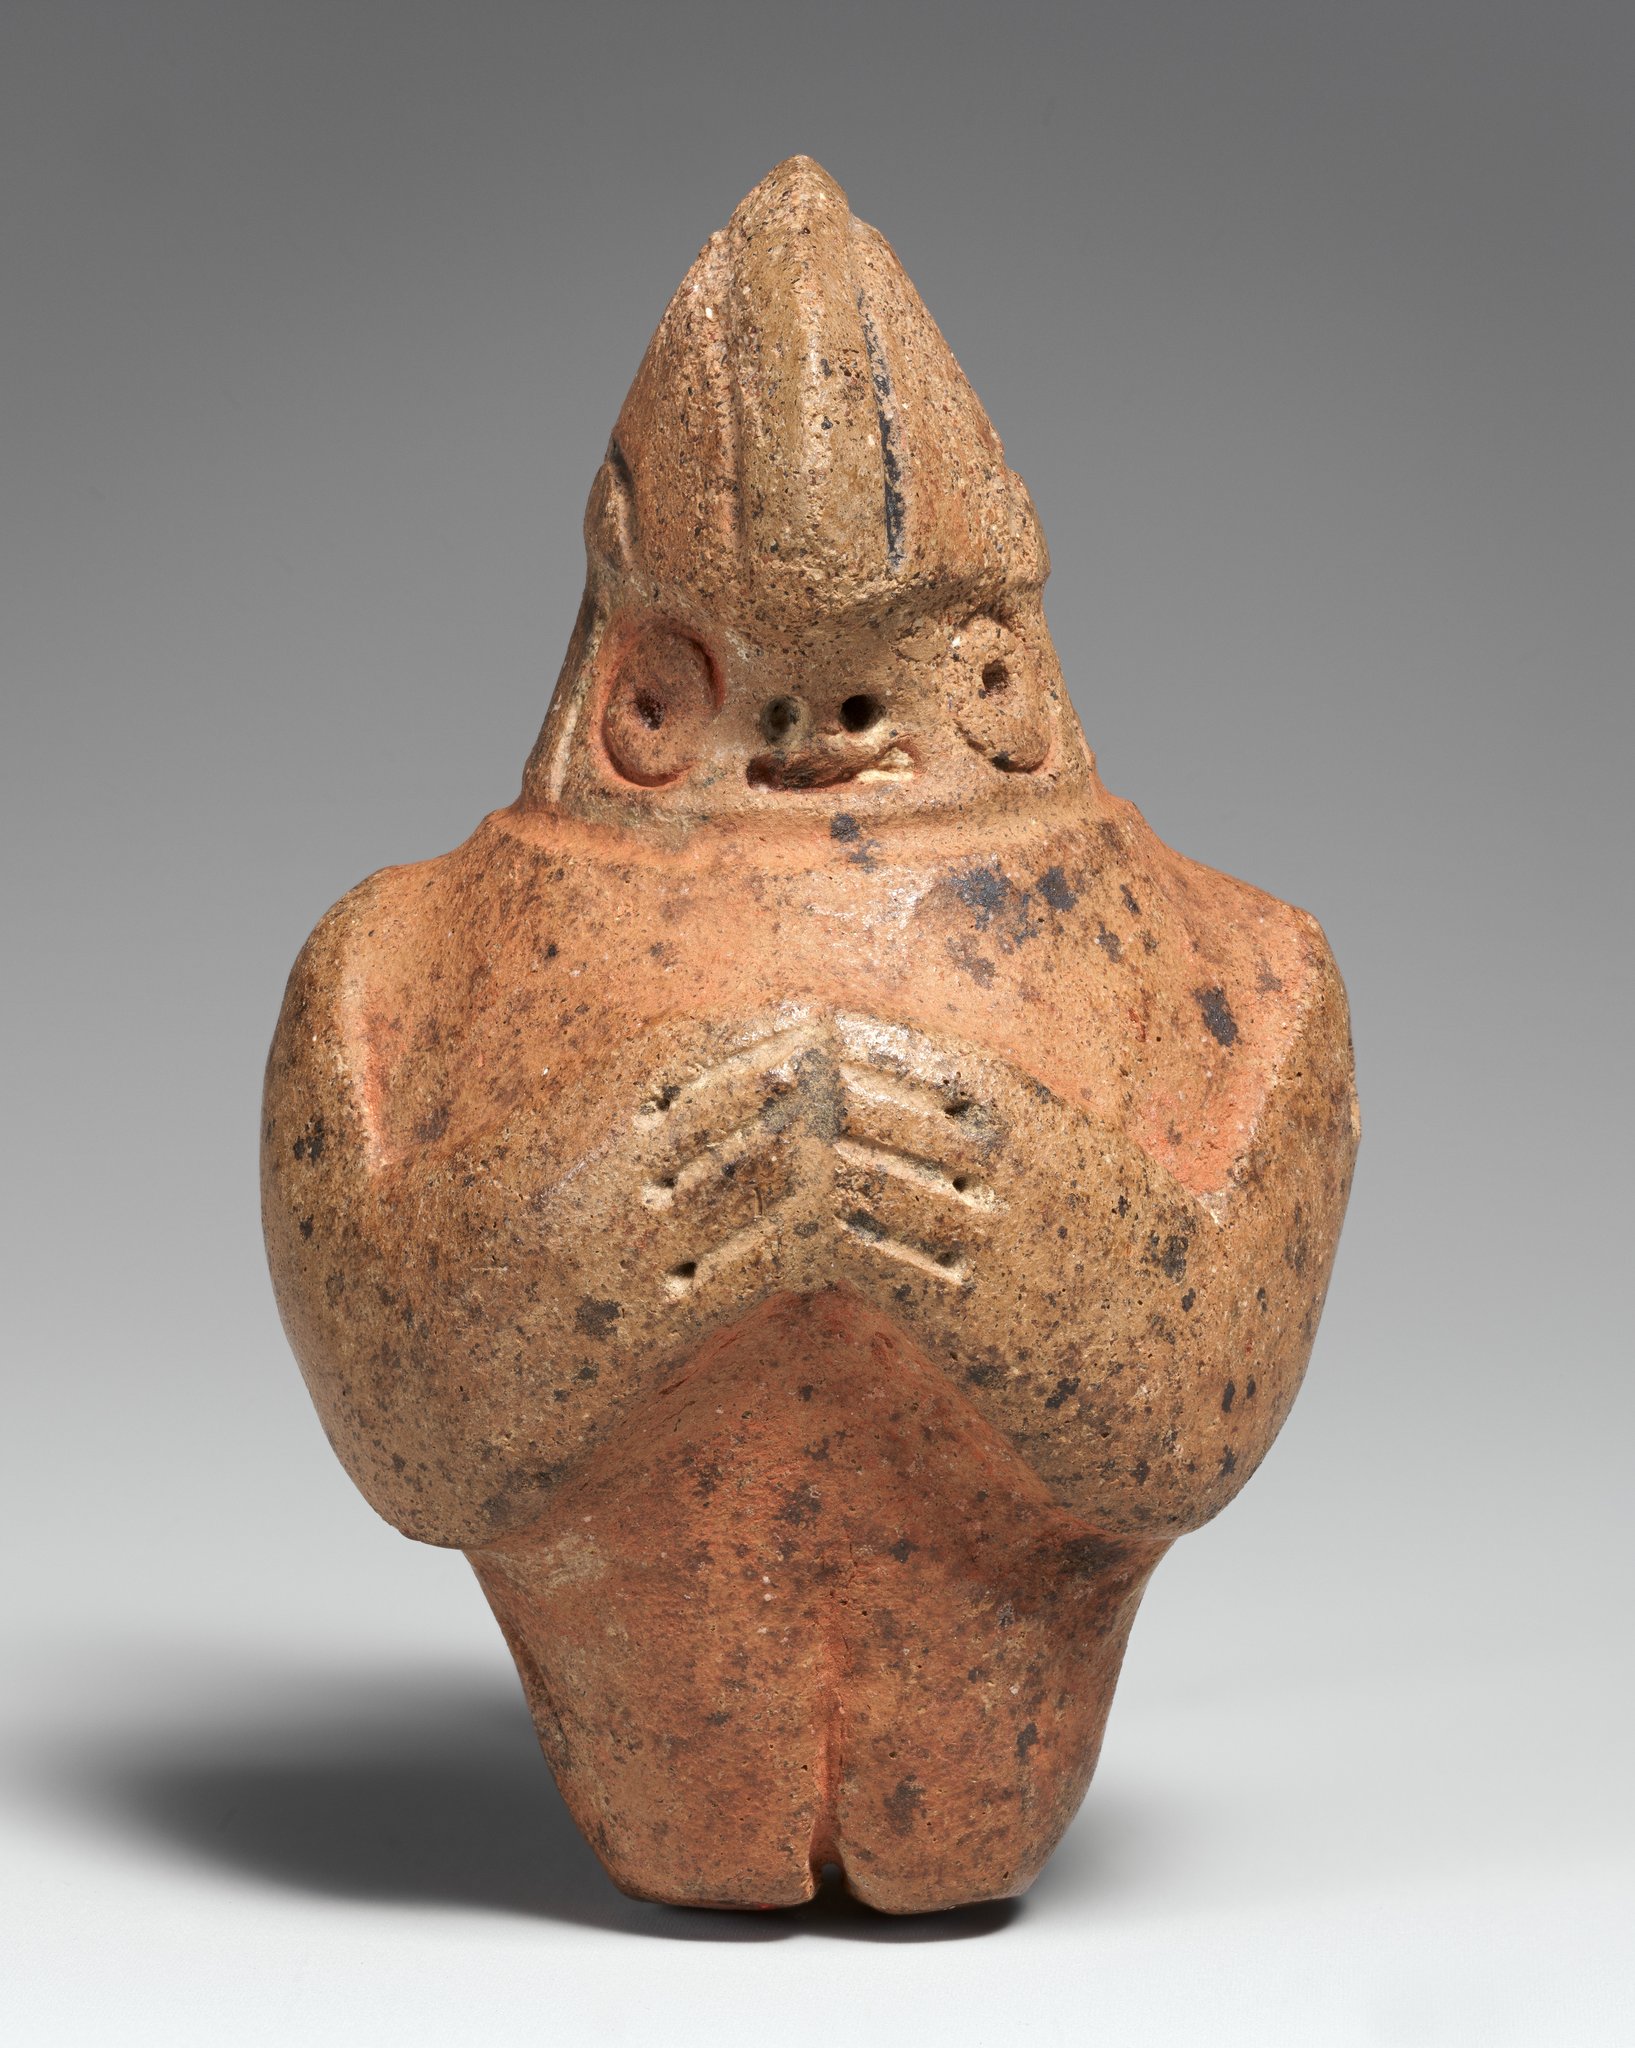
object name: whistle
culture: cupisnique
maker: cupisnique artist(s)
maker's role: artist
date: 1200-500 BCE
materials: ceramic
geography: peru